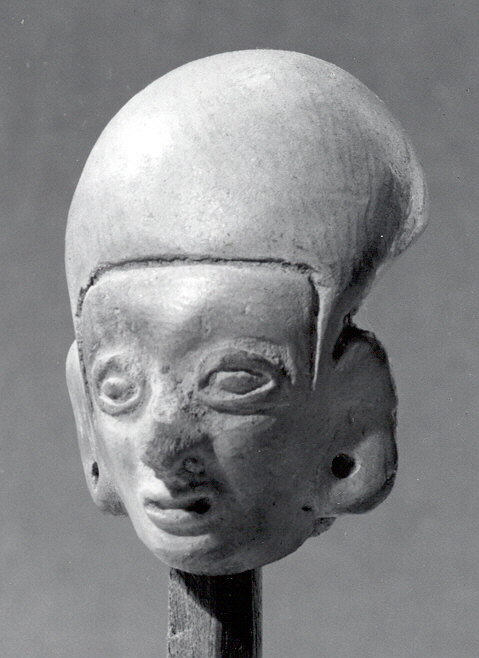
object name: head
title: Head, from a Figure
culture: tolita-tumaco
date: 1-500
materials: ceramic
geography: colombia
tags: human figures,heads